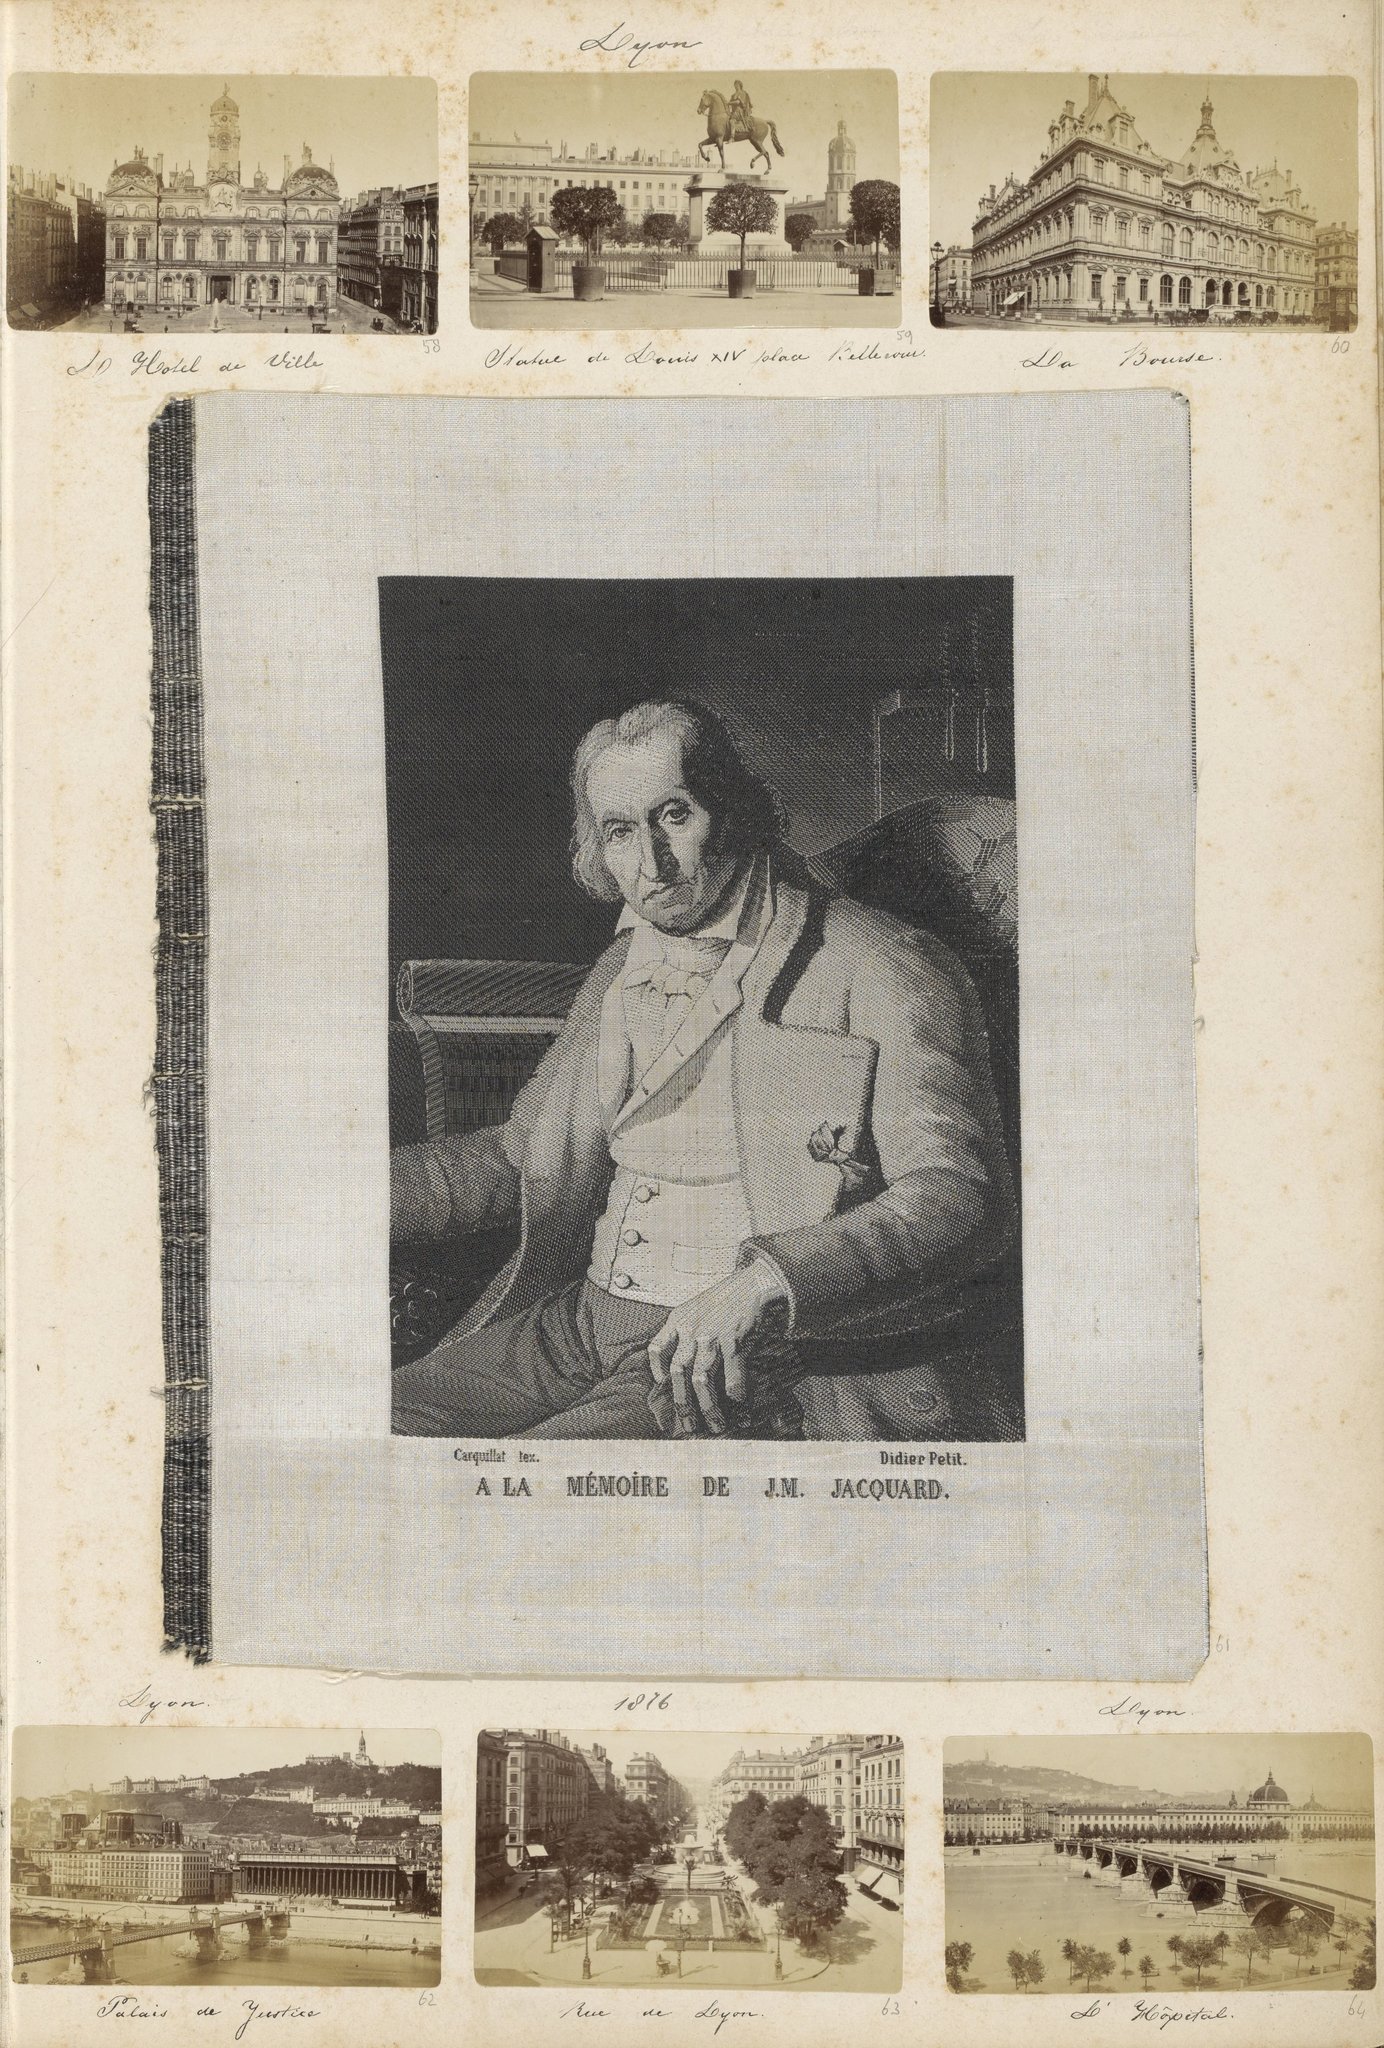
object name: album leaf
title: Gezicht op het Paleis van Justitie van Lyon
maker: Anonymous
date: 1876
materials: paper, photographic support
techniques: albumen print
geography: lyon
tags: court building, lyon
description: Onderdeel van Fotoalbum van Robert Daniel Crommelin (1841-1907).